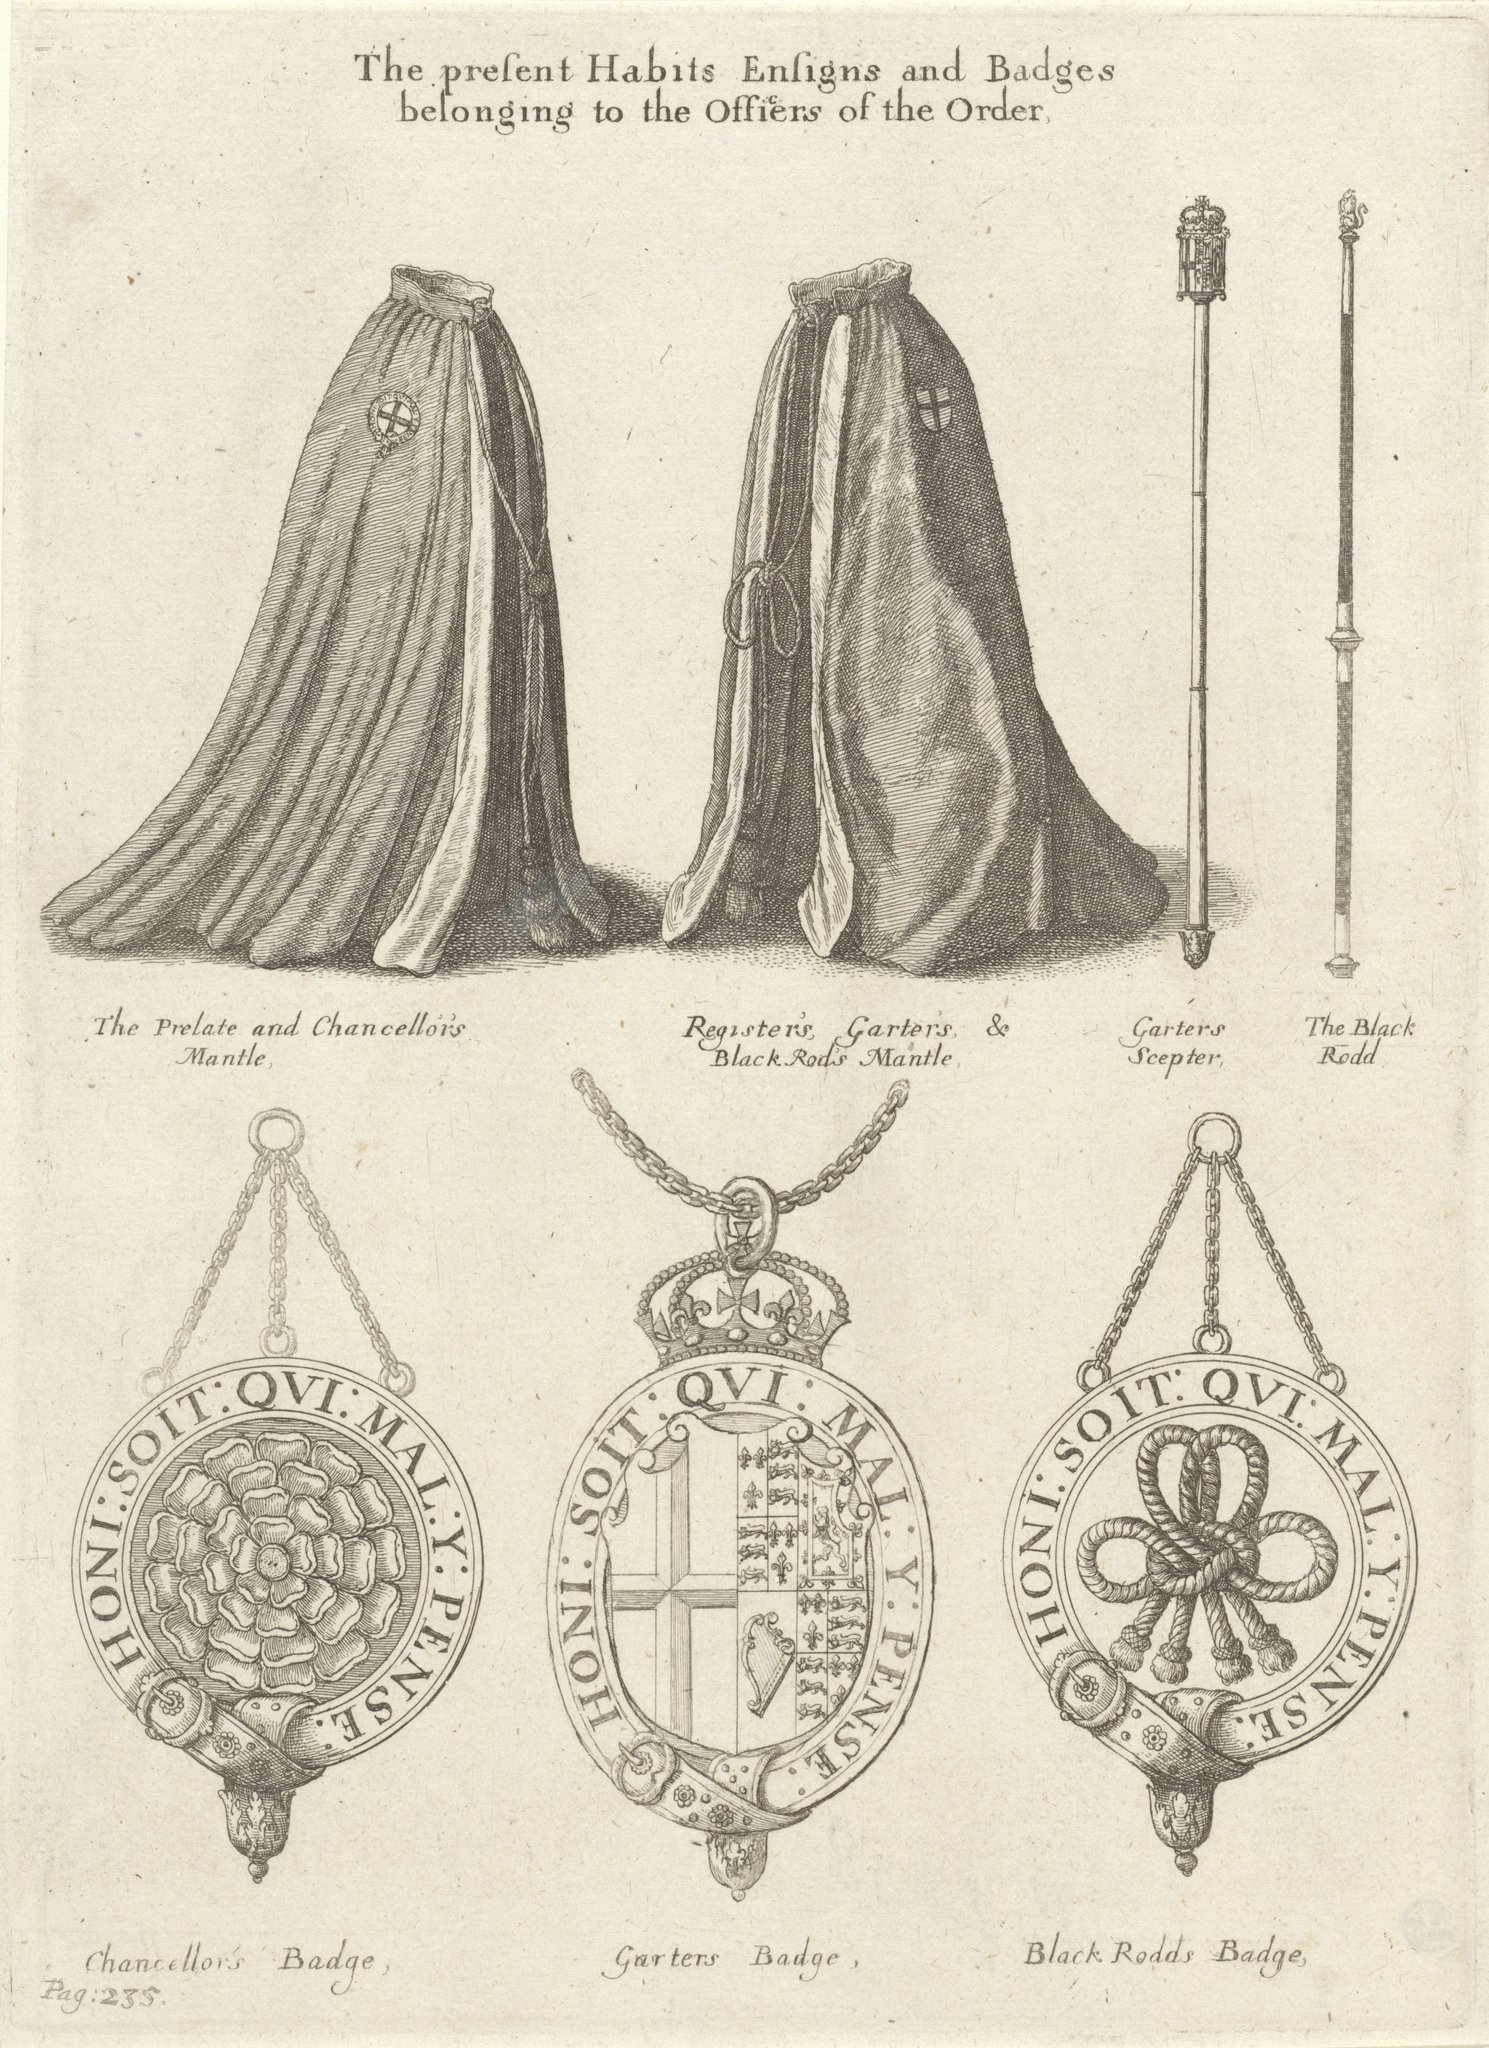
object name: print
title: The present Habits Ensigns and Badges belonging to the Officers of the Order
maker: wenceslaus hollar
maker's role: draughtsman, print maker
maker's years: 1607-1677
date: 1672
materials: paper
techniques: etching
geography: london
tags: clothing (~ knighting ceremony), knighthood order (garter)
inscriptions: collector's mark: Lugt 1337, collector's mark: Lugt 2228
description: Prent opgenomen in: Ashmole, Elias. Institution, Laws and Ceremonies of the Most Noble Order of the Garter, 1672, 1693.